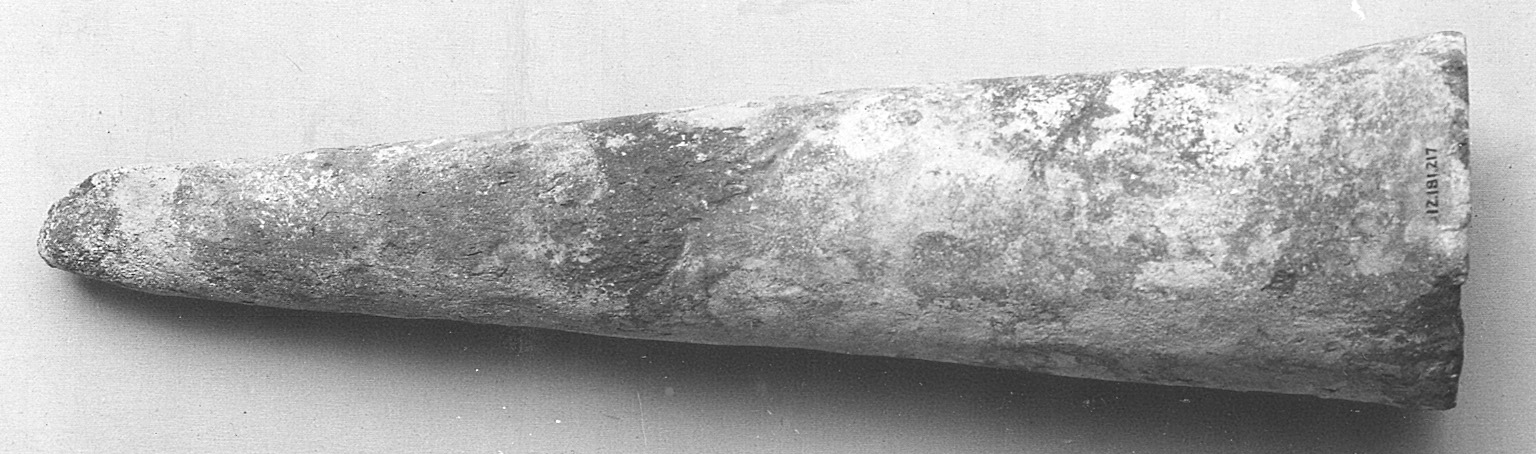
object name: cone, uninscribed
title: Uninscribed Funerary Cone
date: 2124-1981 BCE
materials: paint, pottery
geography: egypt